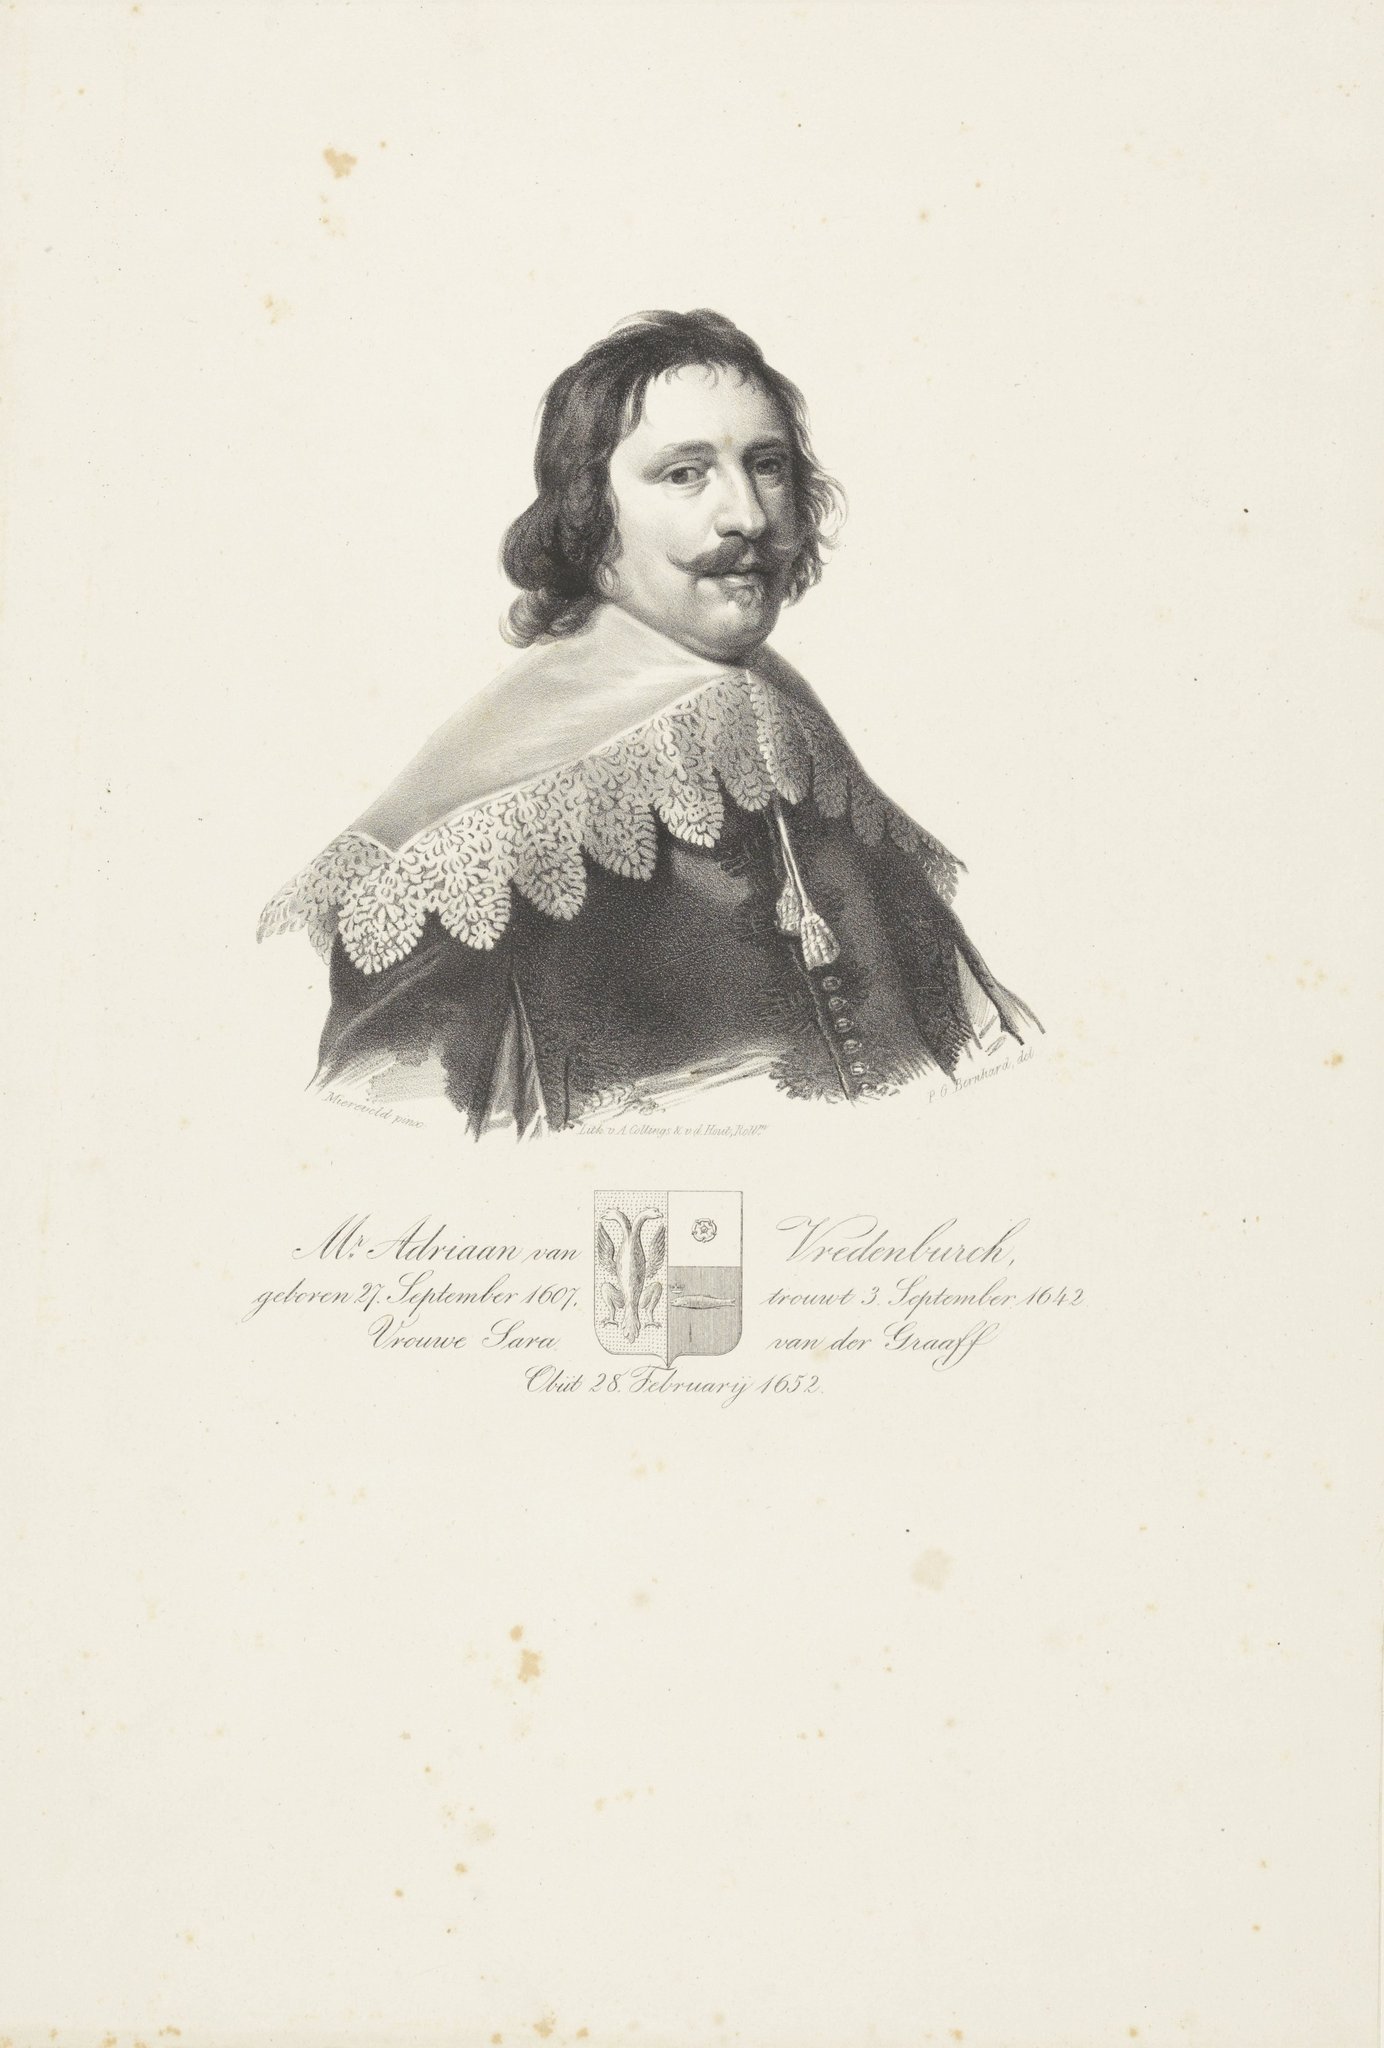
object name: print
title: Portret van Adriaan van Vredenburch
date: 1823-1880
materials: paper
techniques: lithograph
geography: the hague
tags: historical persons, armorial bearing, heraldry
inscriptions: collector's mark: Lugt 2228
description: Onder het portret de naam, geboorte- trouw- en sterfdatum en het familiewapen van de geportretteerde. Daaronder de signatuur van de geportretteerde.